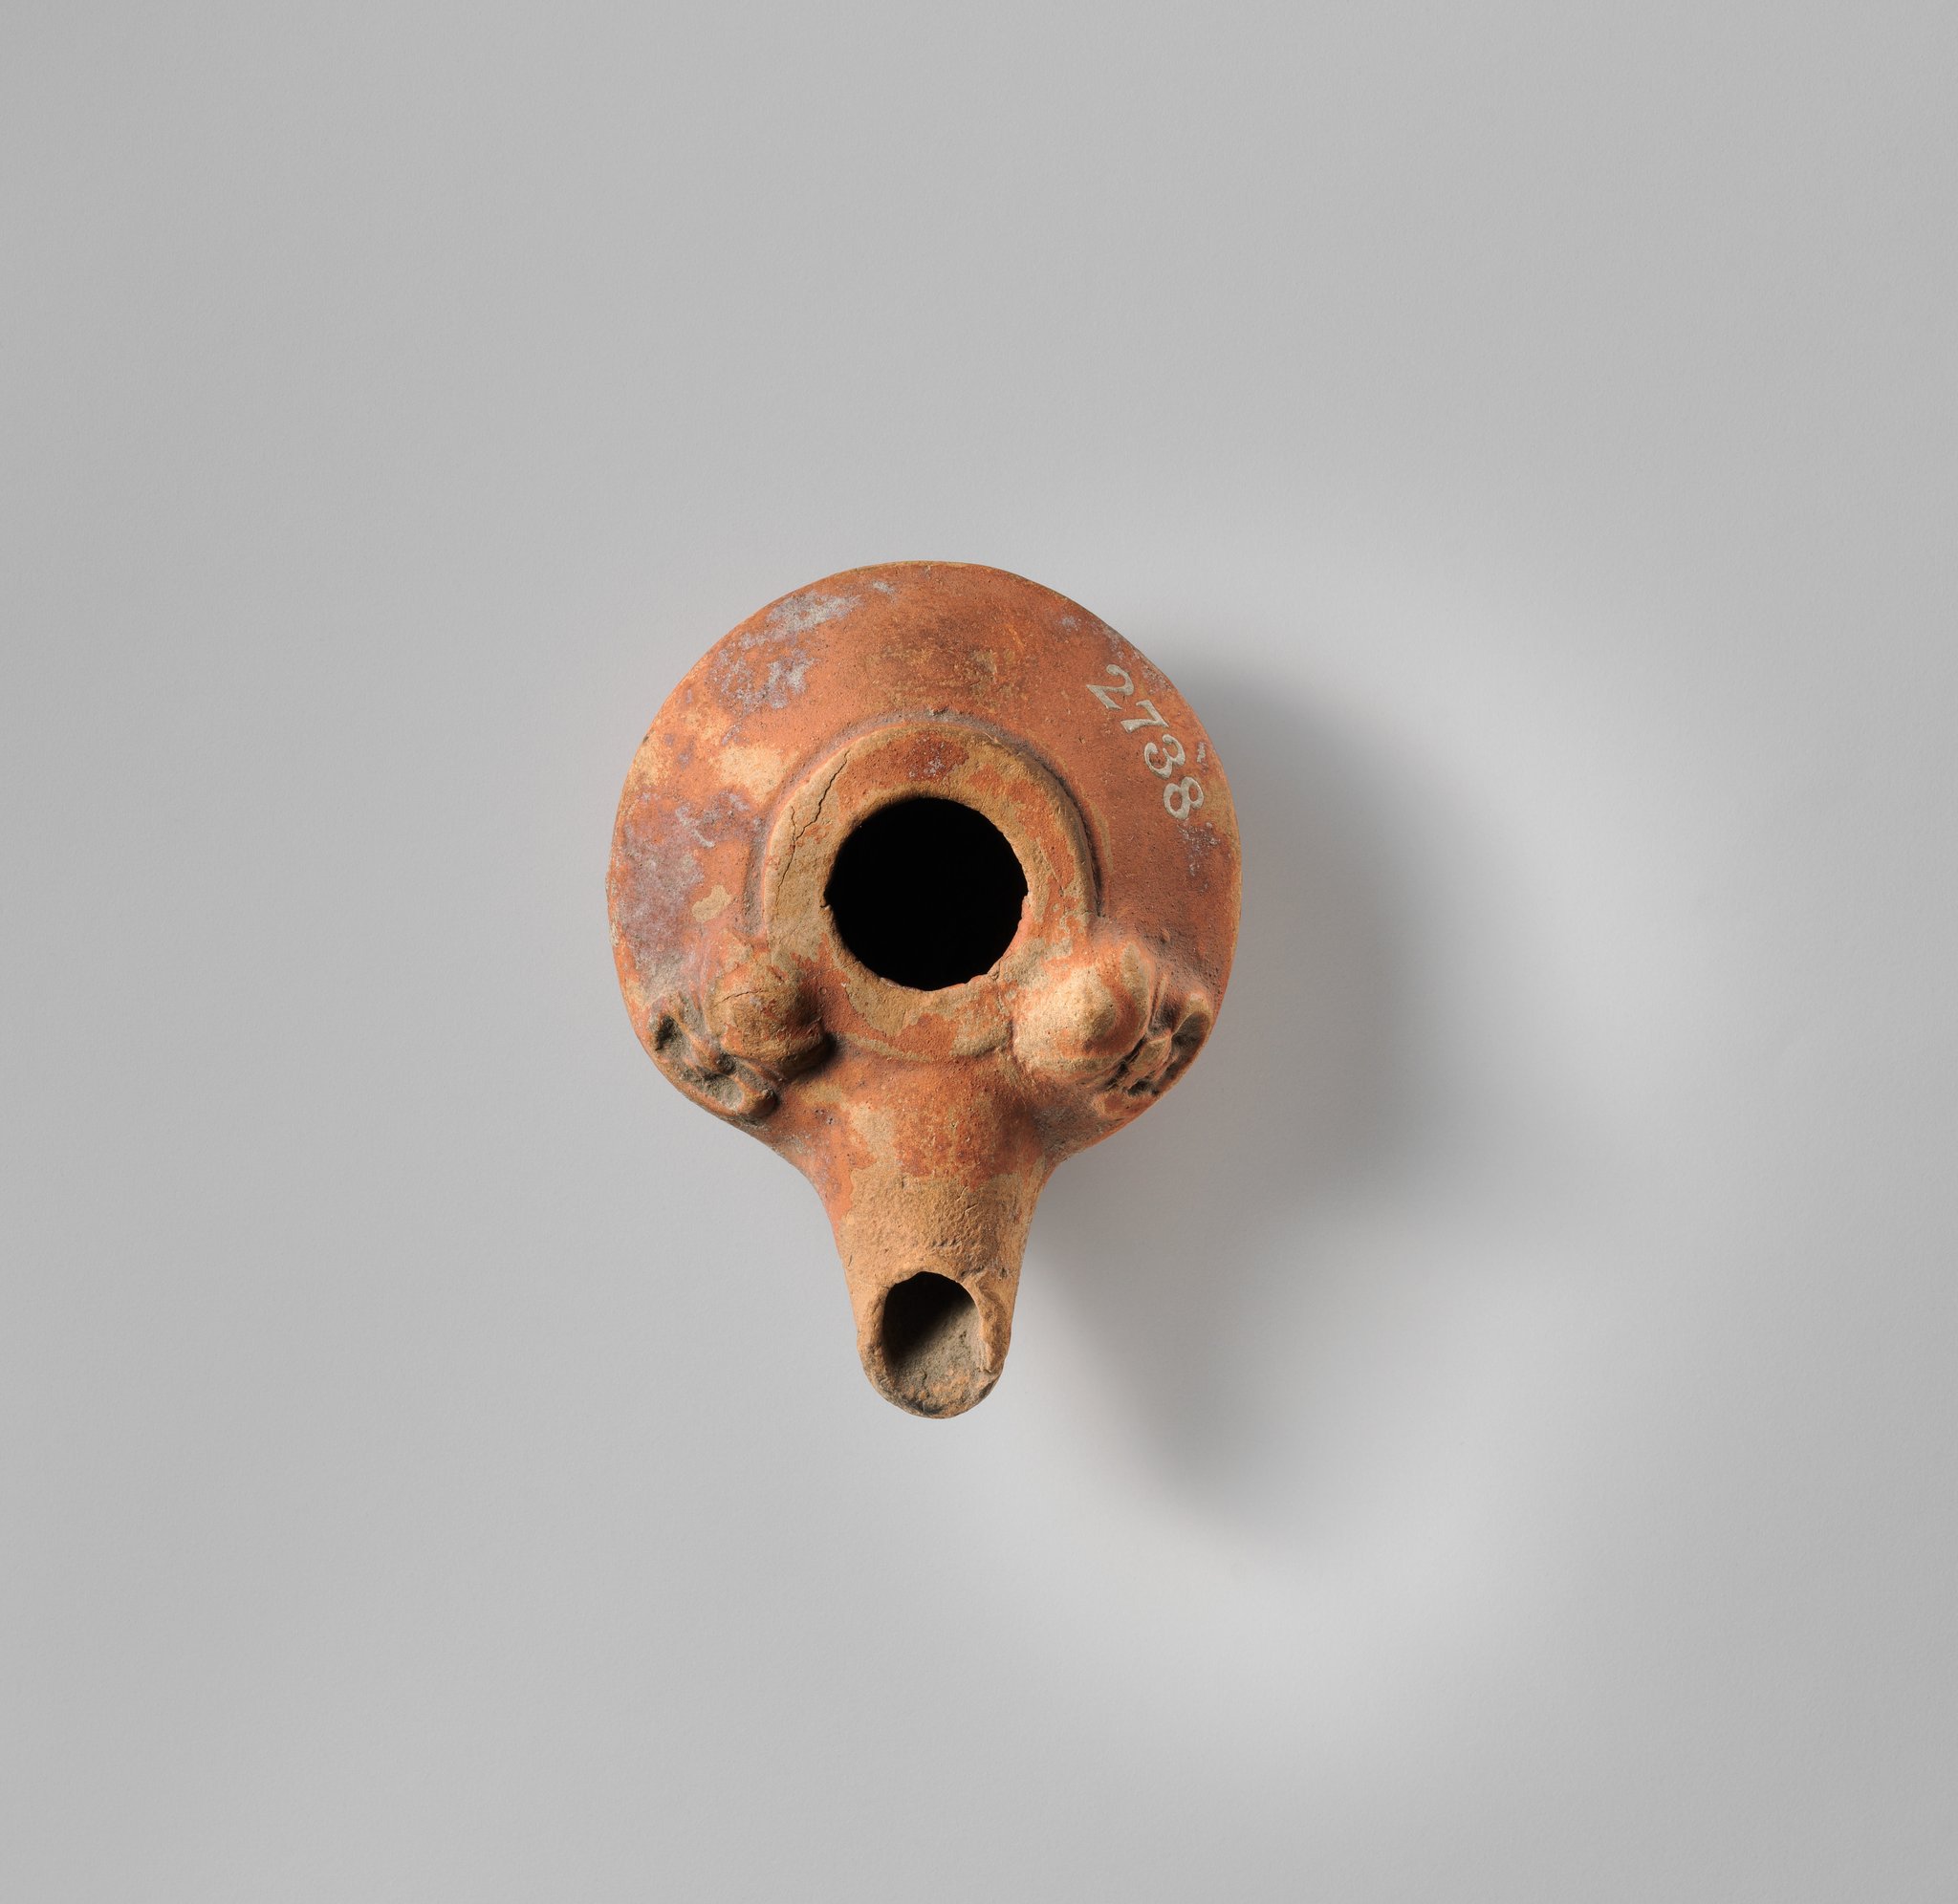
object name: lamp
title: Terracotta oil lamp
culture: greek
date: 7000 BCE-330 CE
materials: terracotta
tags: masks